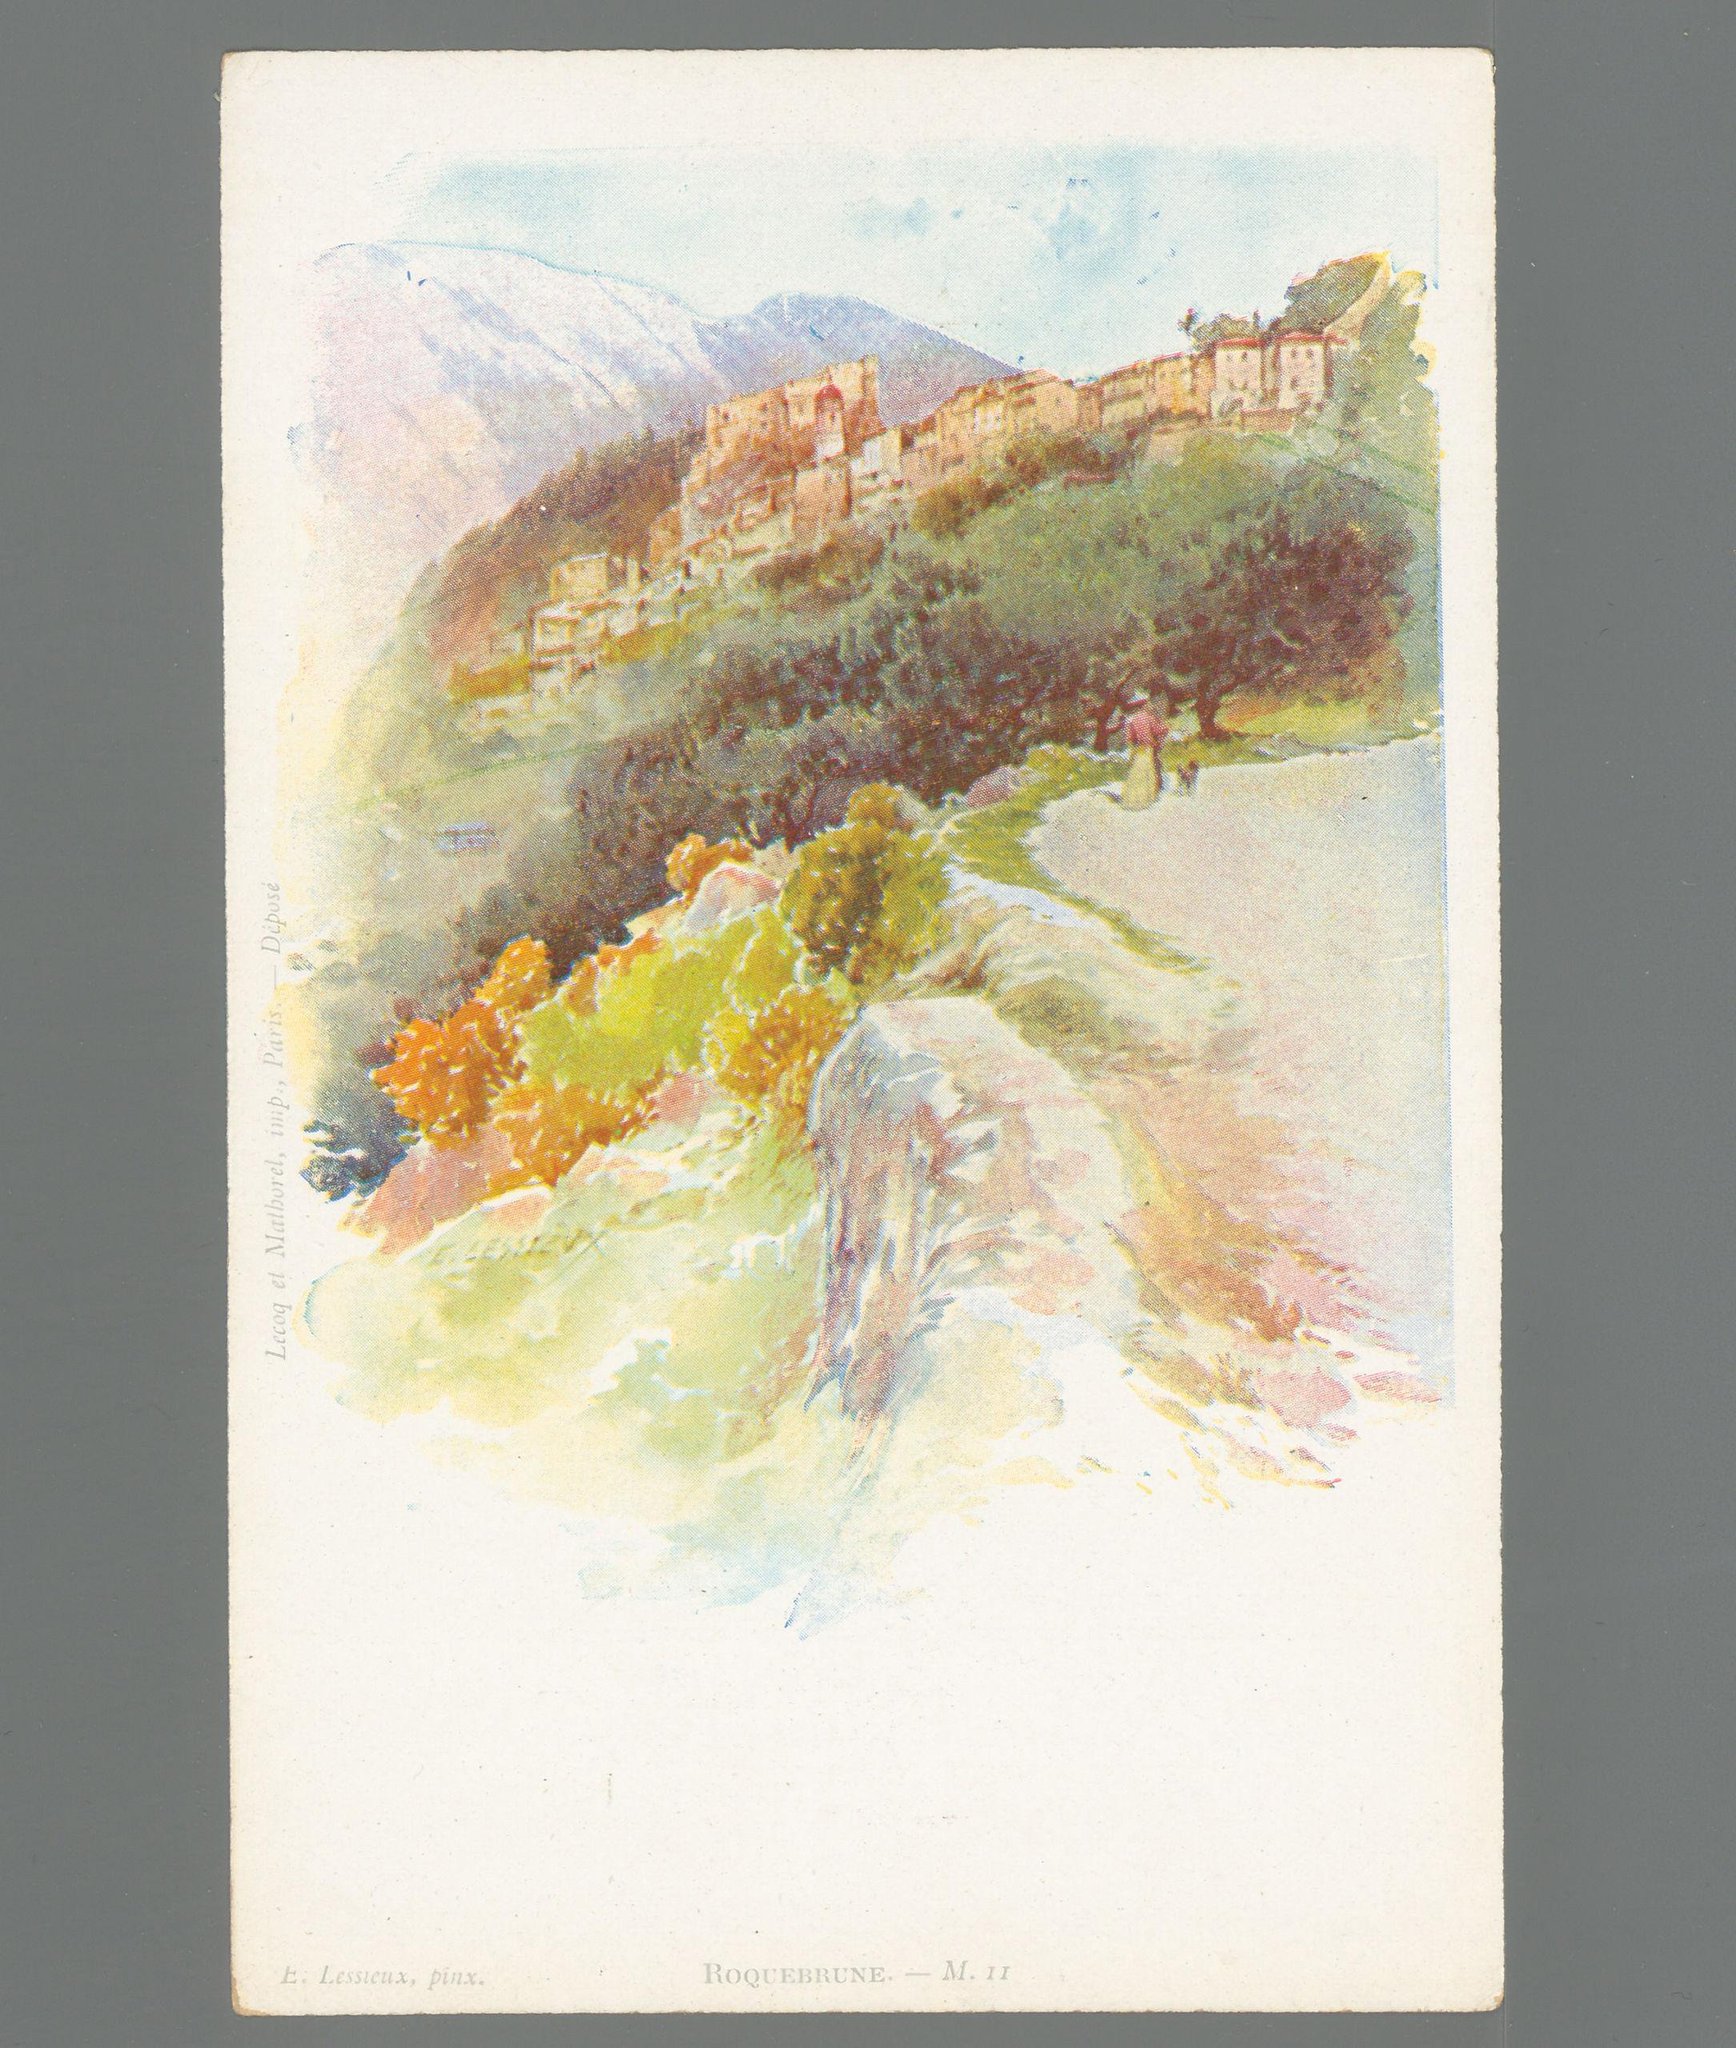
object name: reproduction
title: Roquebrune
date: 1892-1904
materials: cardboard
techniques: writing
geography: paris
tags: prospect of village, silhouette of village, mountains (+ landscape with figures, staffage)